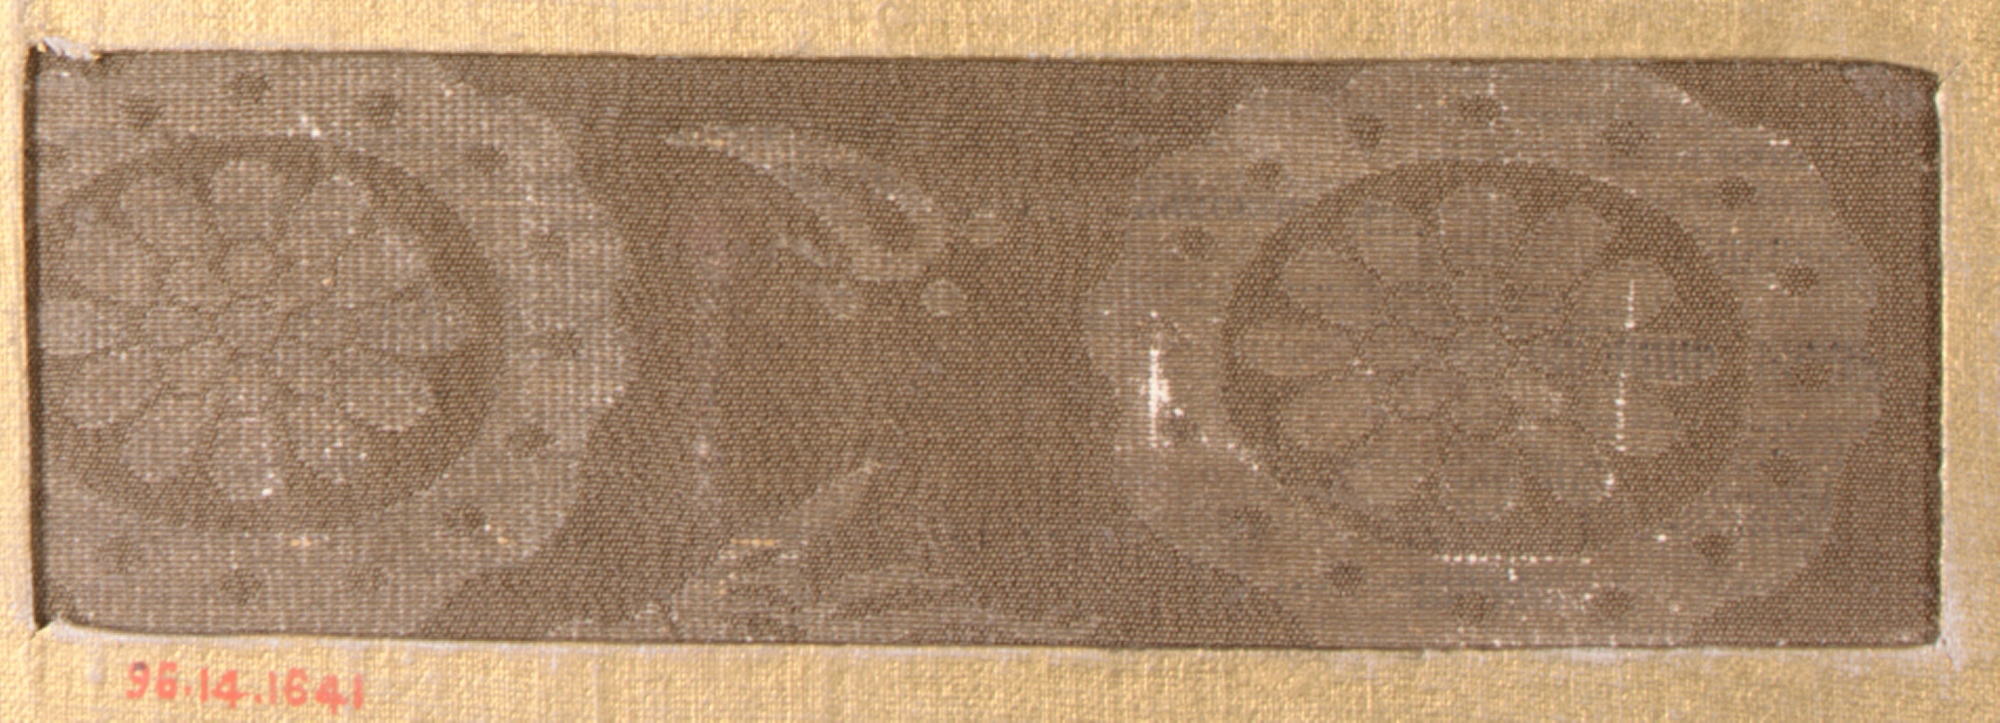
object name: piece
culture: japanese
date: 1701-1900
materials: silk